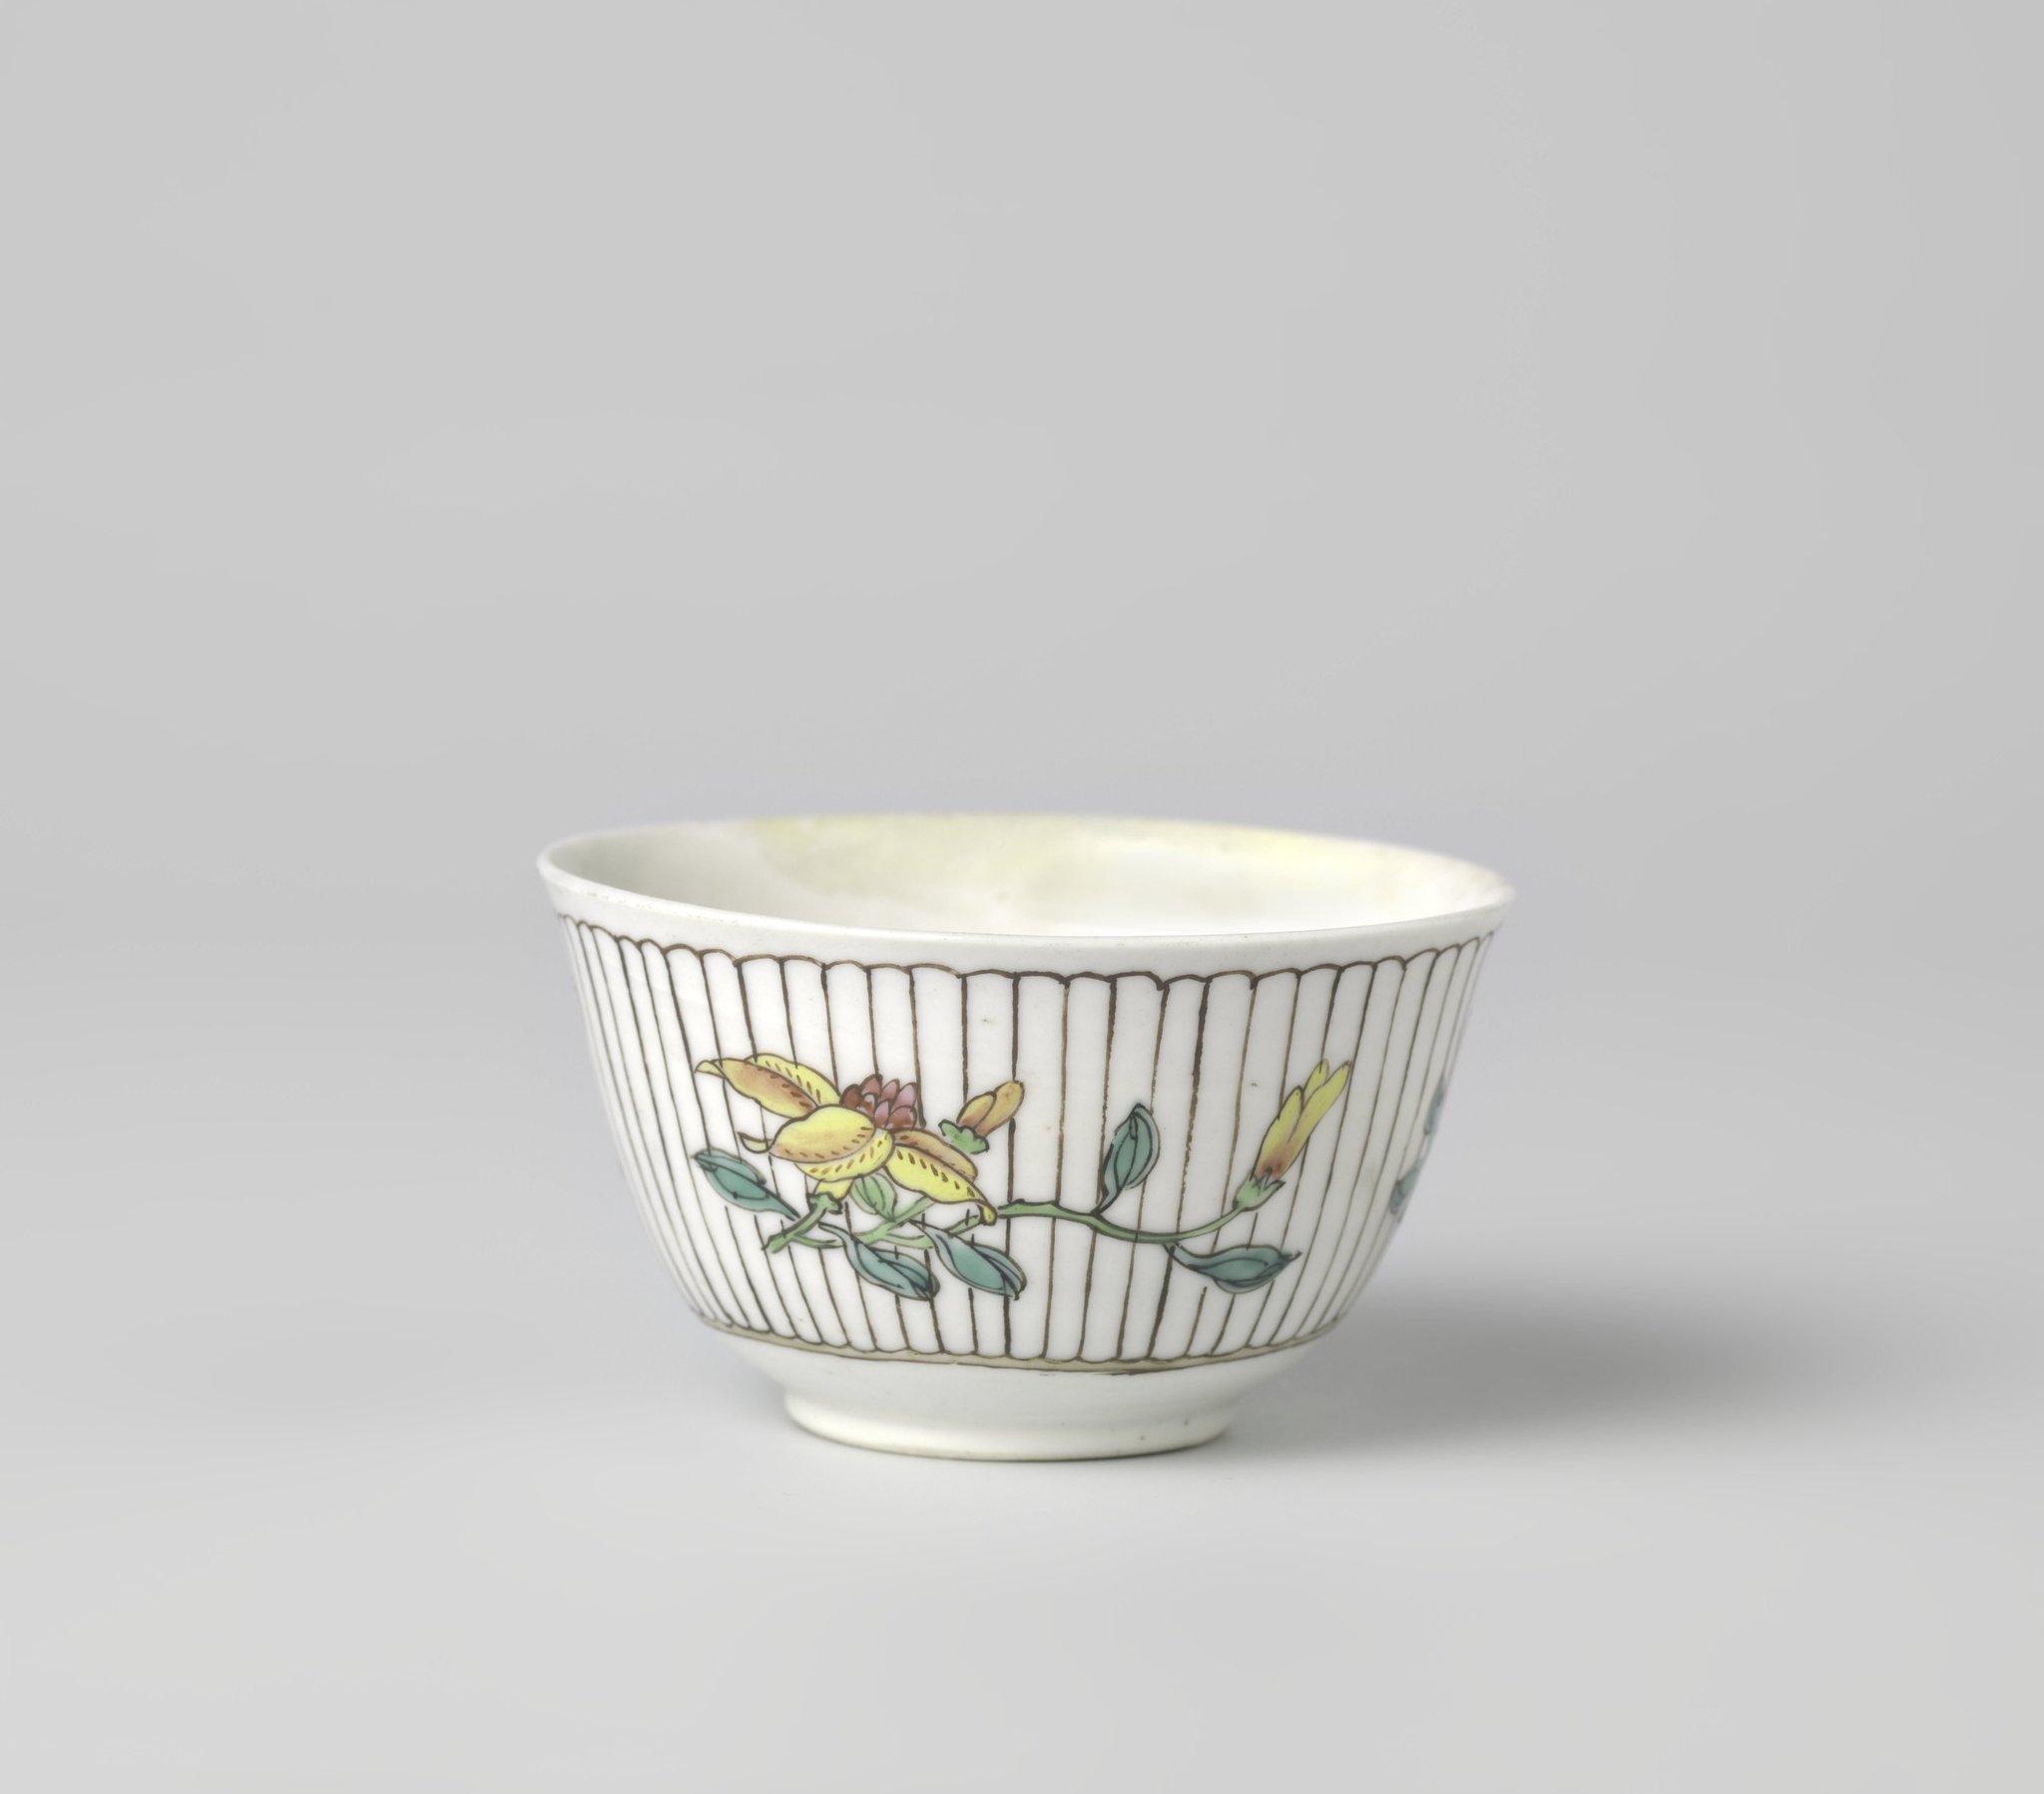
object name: cup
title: Bell-shaped cup with three flower sprays on a vertically striped ground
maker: Anonymous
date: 1725-1749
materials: glaze, gold, paint, porcelain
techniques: firing, gilding, turning, vitrification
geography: china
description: Klokvormige kop van porselein, beschilderd op het glazuur in blauw, rood, roze, groen, geel, zwart en goud. Op de buitenzijde drie bloemtakken (pioen, magnolia, iris) op een verticaal gestreepte grond; op de bodem een gestileerde bloem. Rand gerestaureerd. Famille rose.